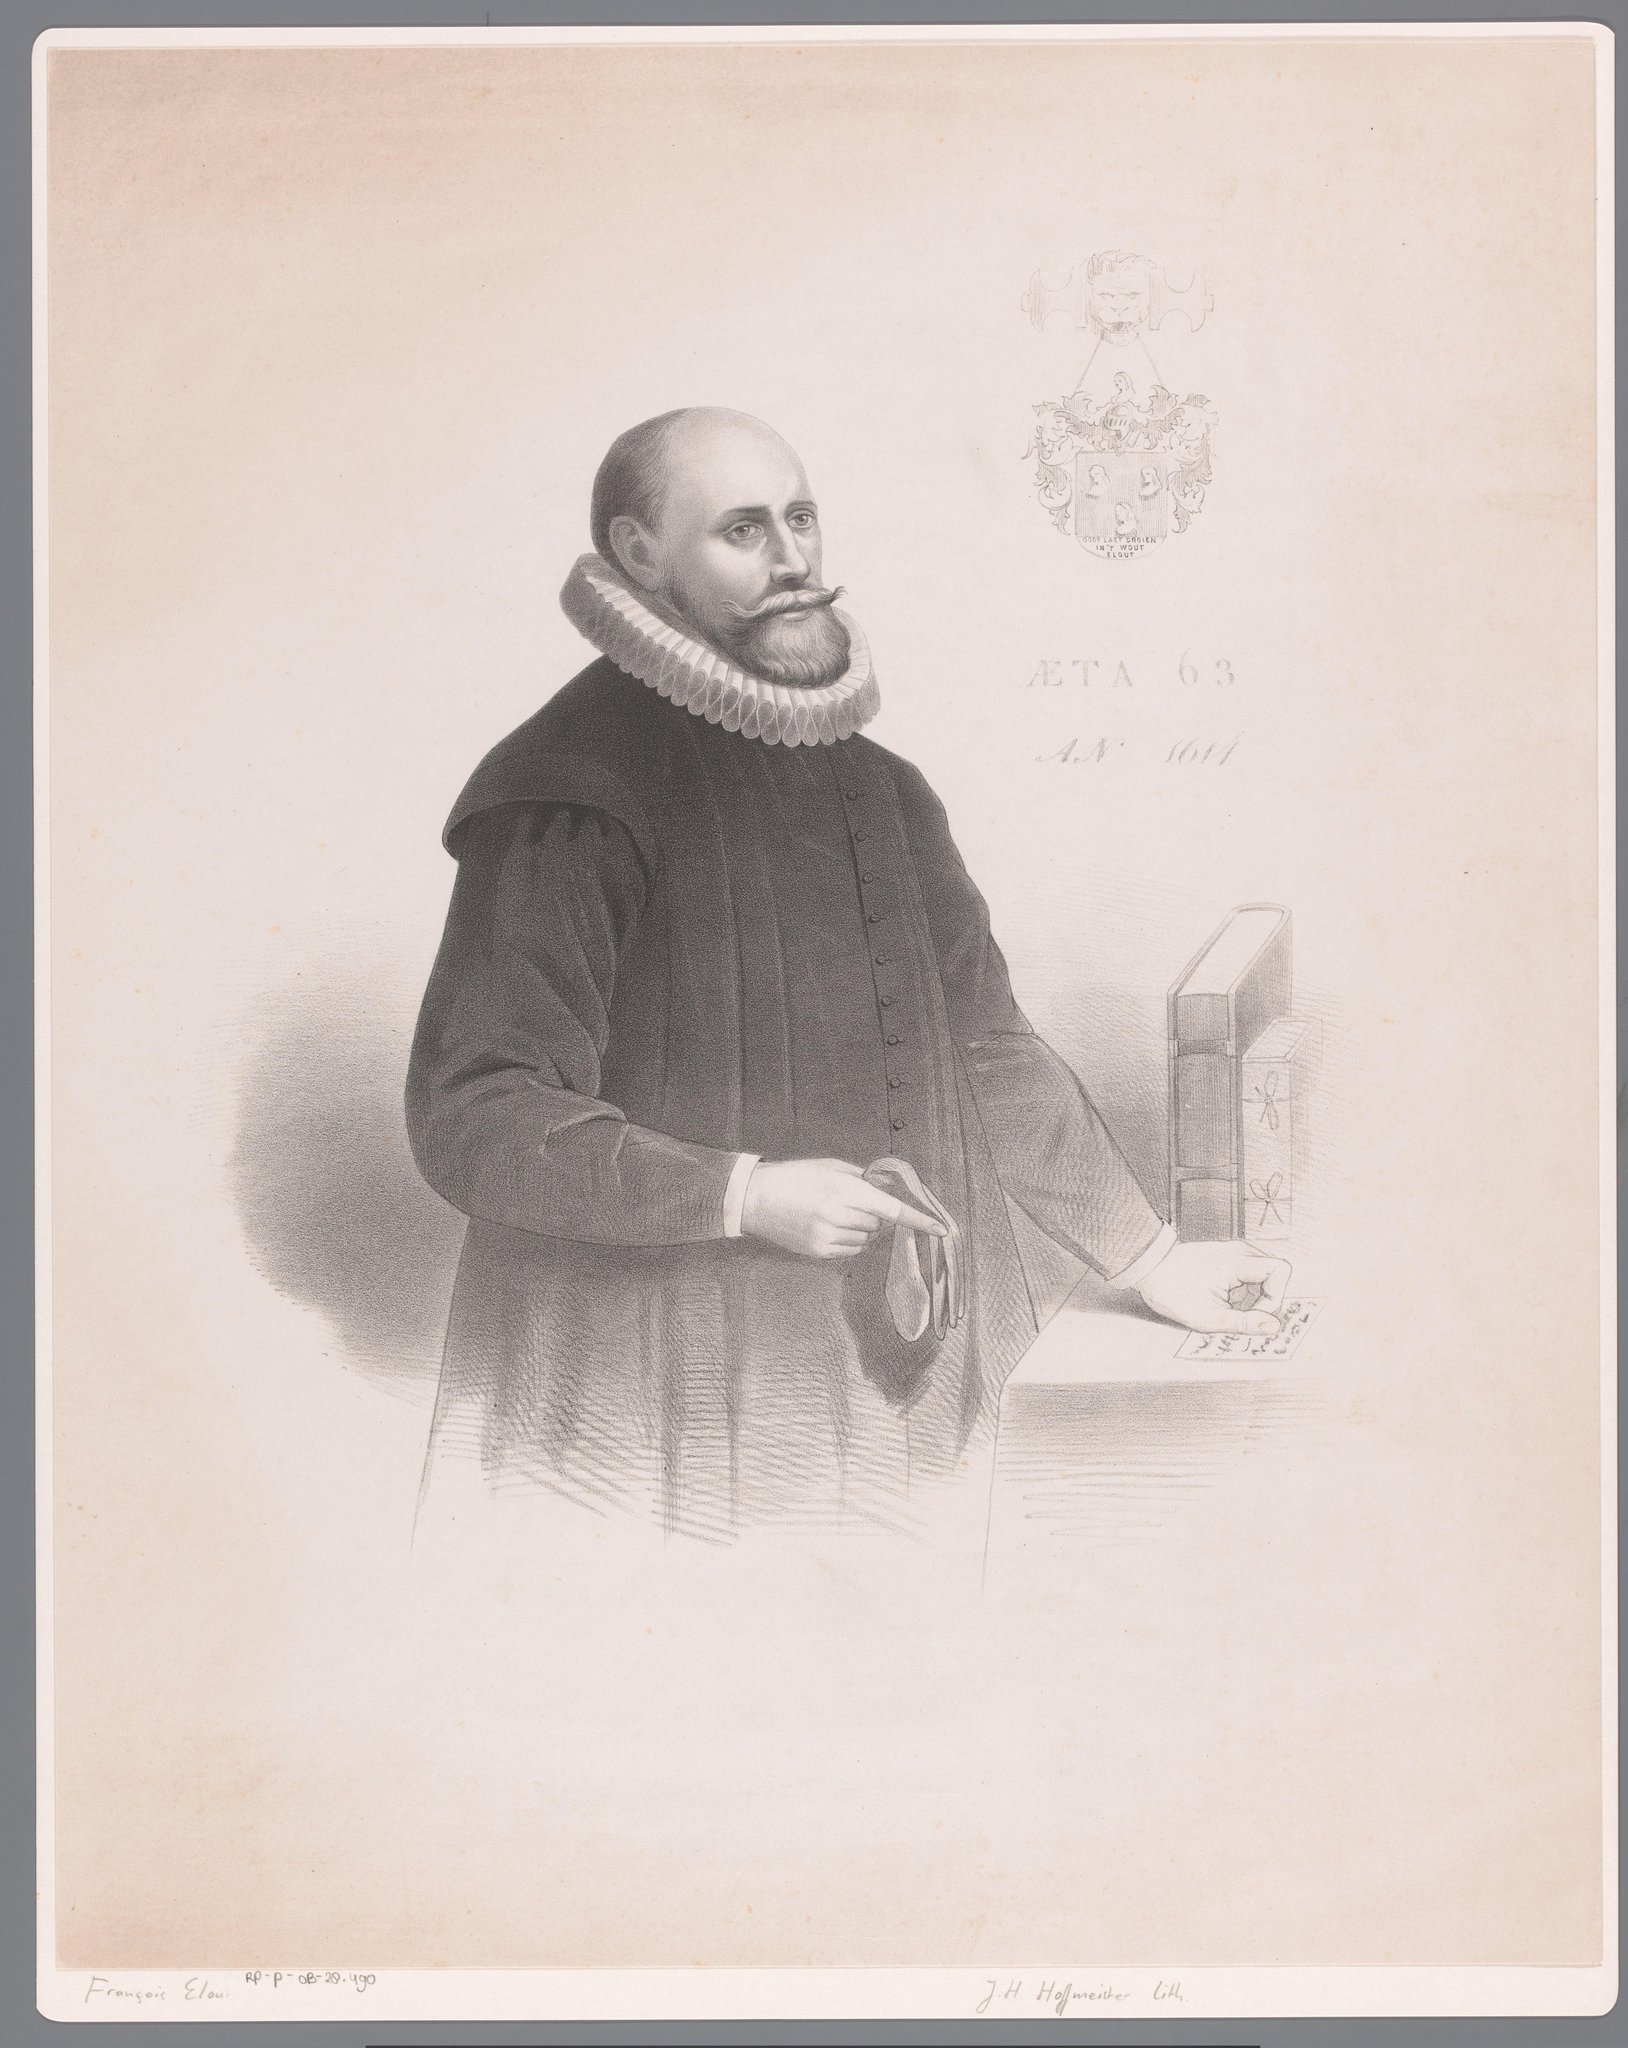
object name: print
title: François Elout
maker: johan hendrik hoffmeister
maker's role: print maker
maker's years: 1823-1904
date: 1851-1883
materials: paper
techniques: lithograph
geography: netherlands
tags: haarlem, painter, neck-gear ~ clothing (with name), letter, envelope, historical persons (+ three-quarter length portrait)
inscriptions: collector's mark: Lugt 2228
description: De geportretteerde staat bij een tafel met daarop boeken en een beschreven vel papier. In zijn rechterhand heeft hij een handschoen. Hij draagt een plooikraag. Rechtsboven het familiewapen van de familie Elout.